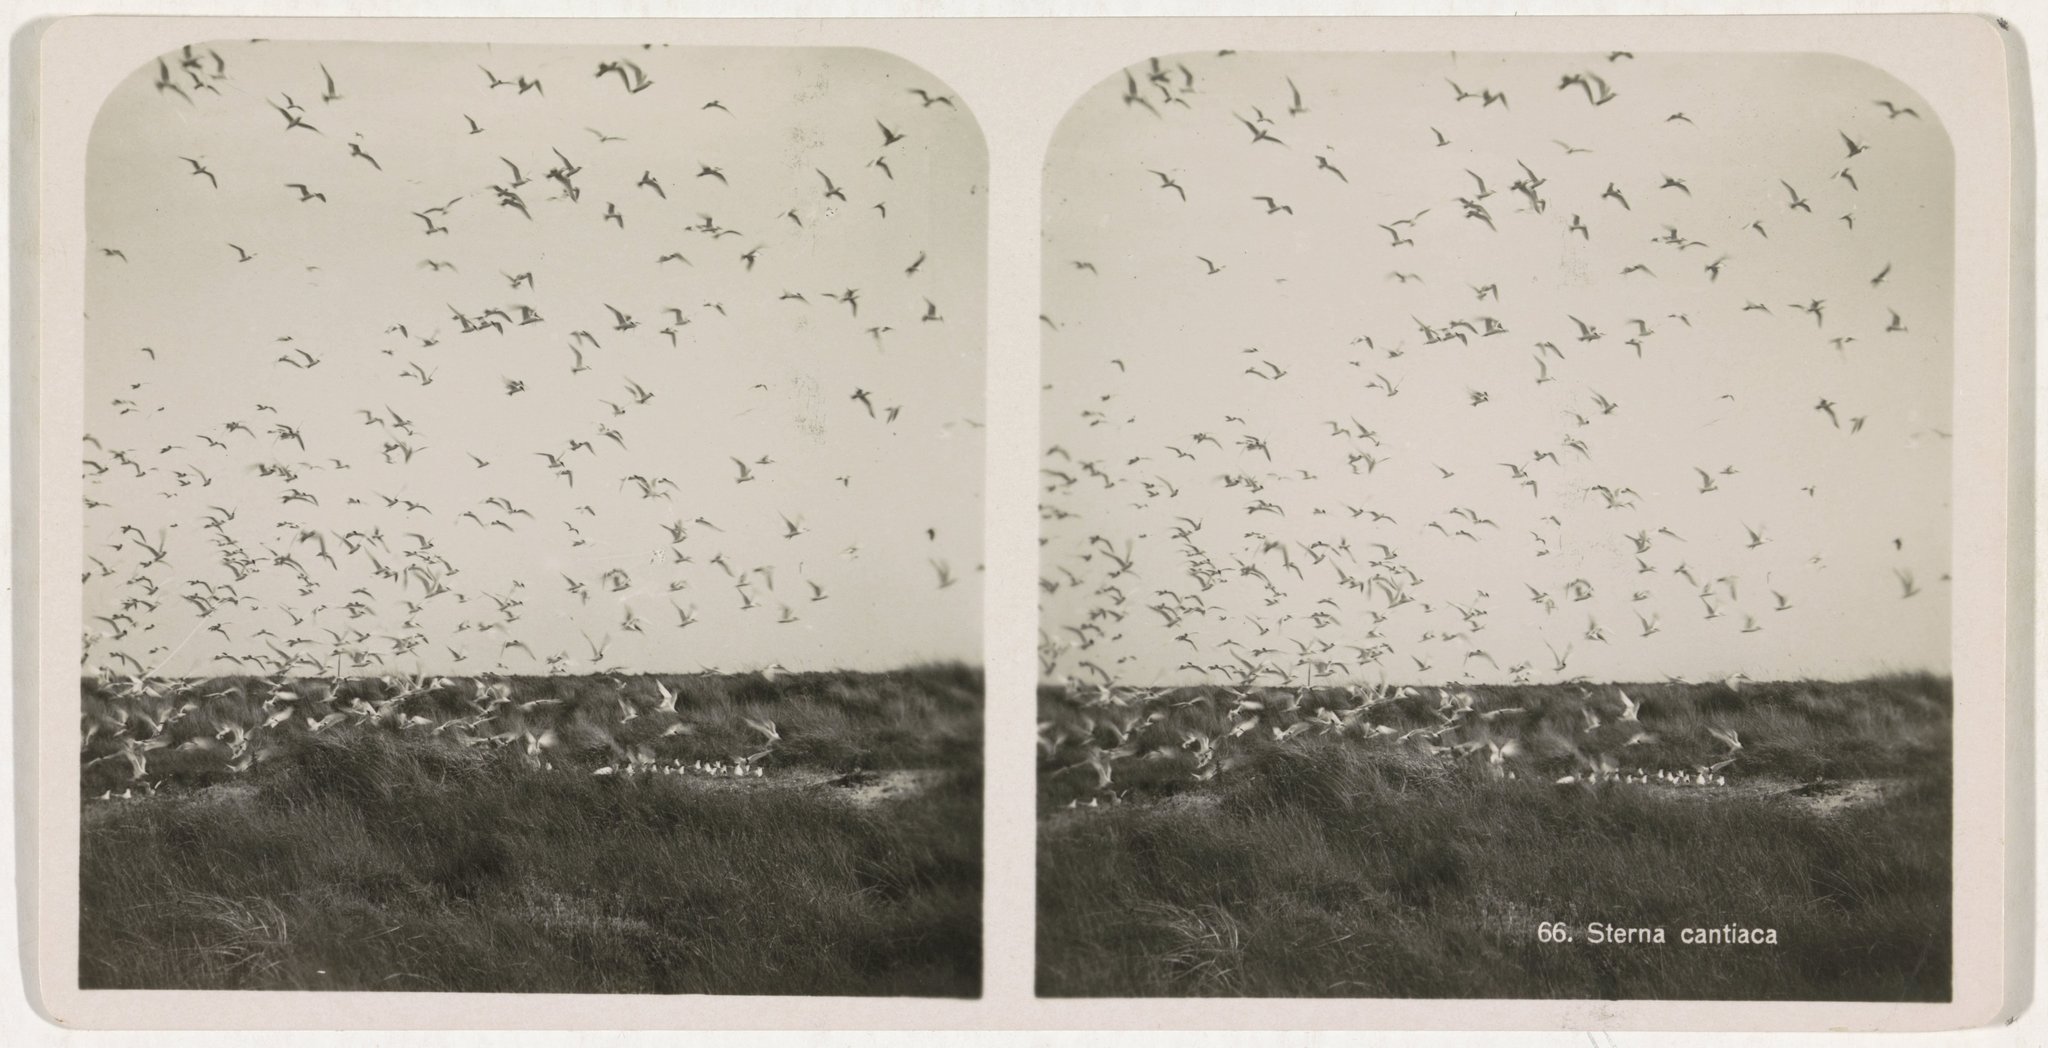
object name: stereograph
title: 66. Sterna cantiaca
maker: adolphe burdet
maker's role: fotograaf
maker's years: 1860-1940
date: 1870-1940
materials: photographic support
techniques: gelatin silver print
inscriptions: label: ‘Zee-Zwaluwen.’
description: De foto maakt deel uit van een serie van 12 stereofoto's, bewaard in het originele mapje. De foto's tonen zeevogels in natuurgebied De Bol op Texel.